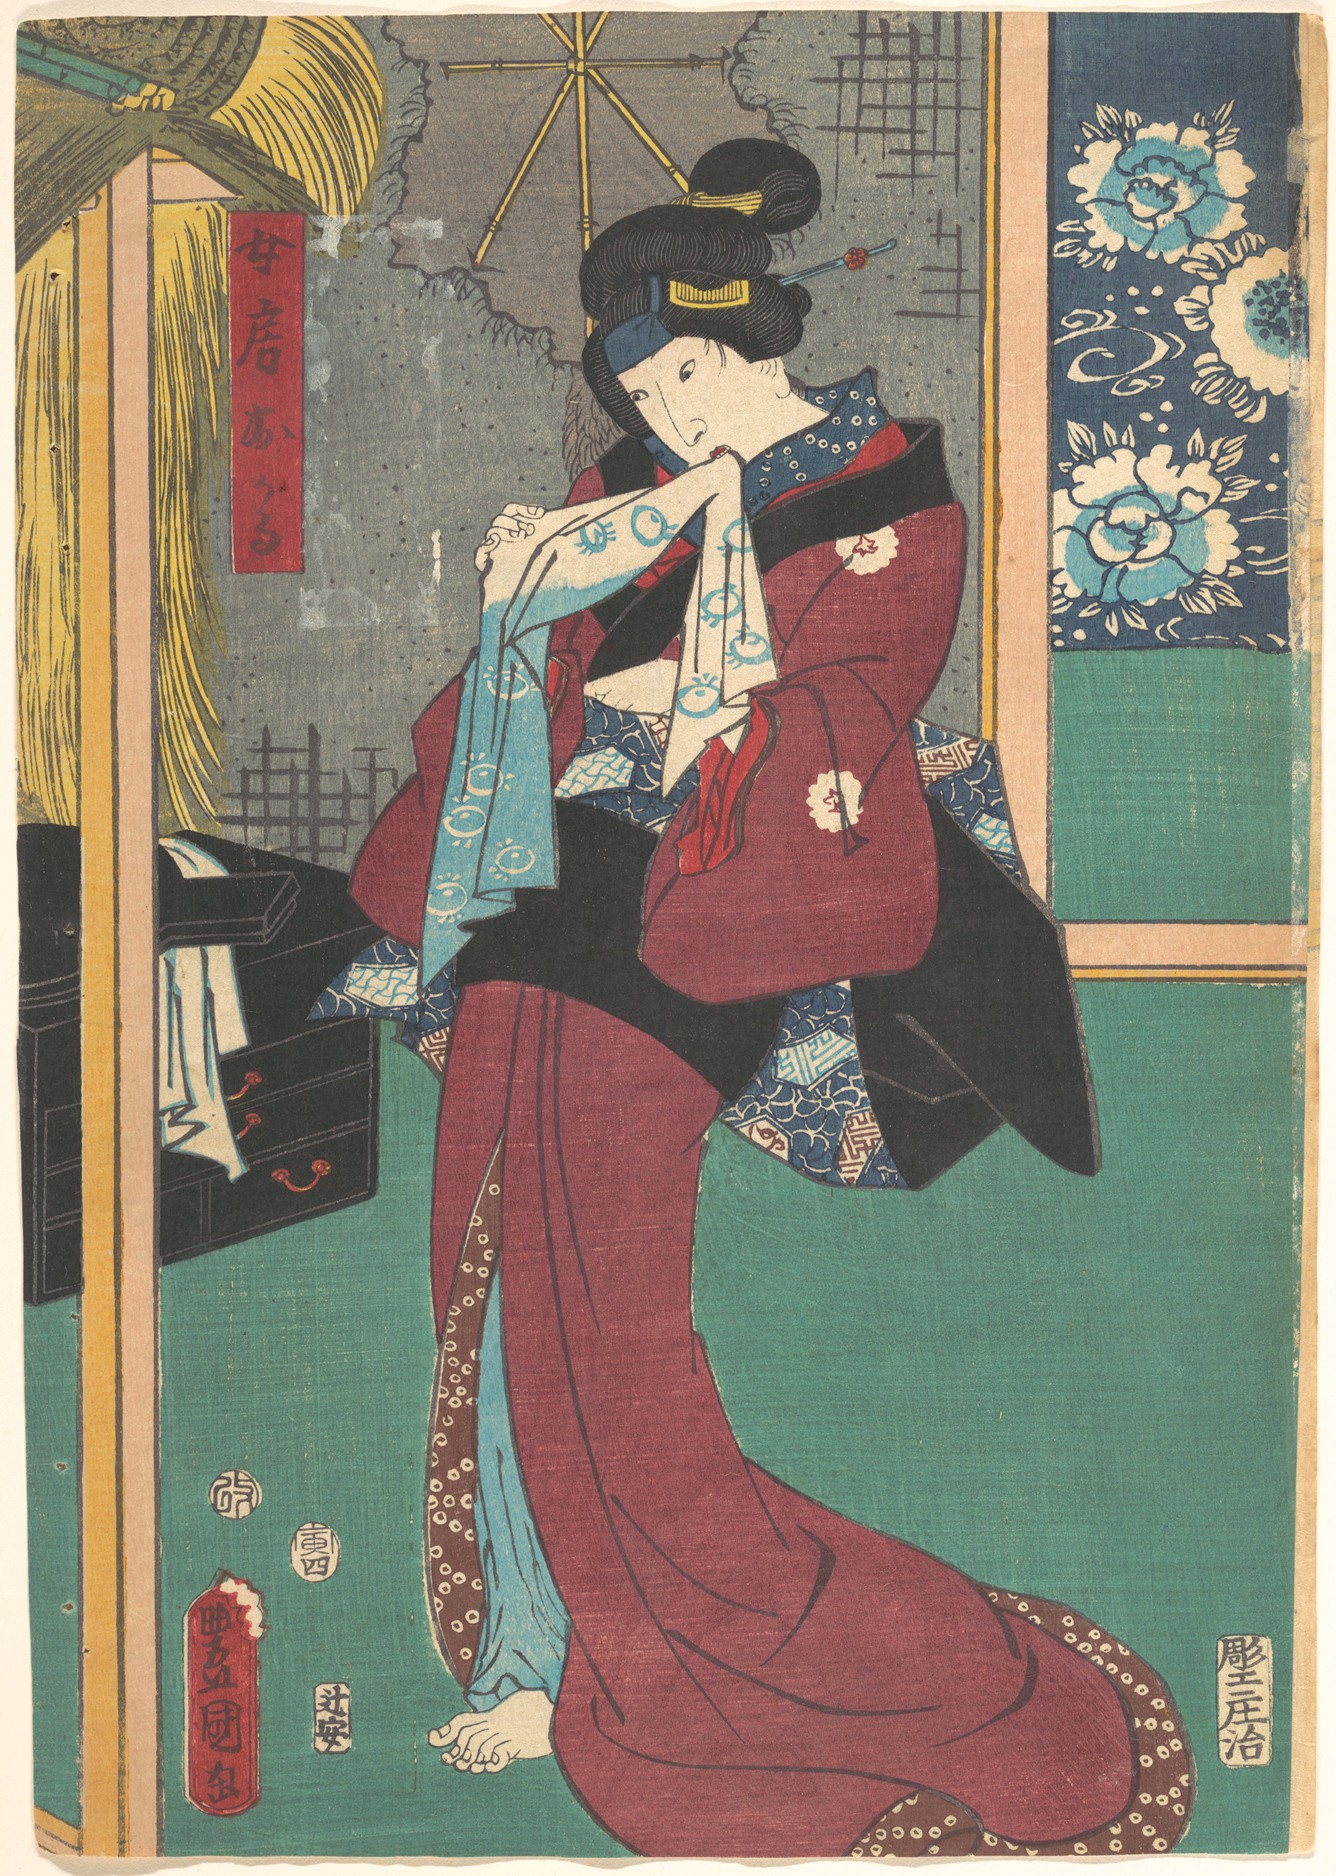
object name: print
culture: japanese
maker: utagawa kunisada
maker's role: artist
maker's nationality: japanese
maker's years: 1786-1864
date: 1801-1900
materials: ink, paper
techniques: woodblock print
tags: women